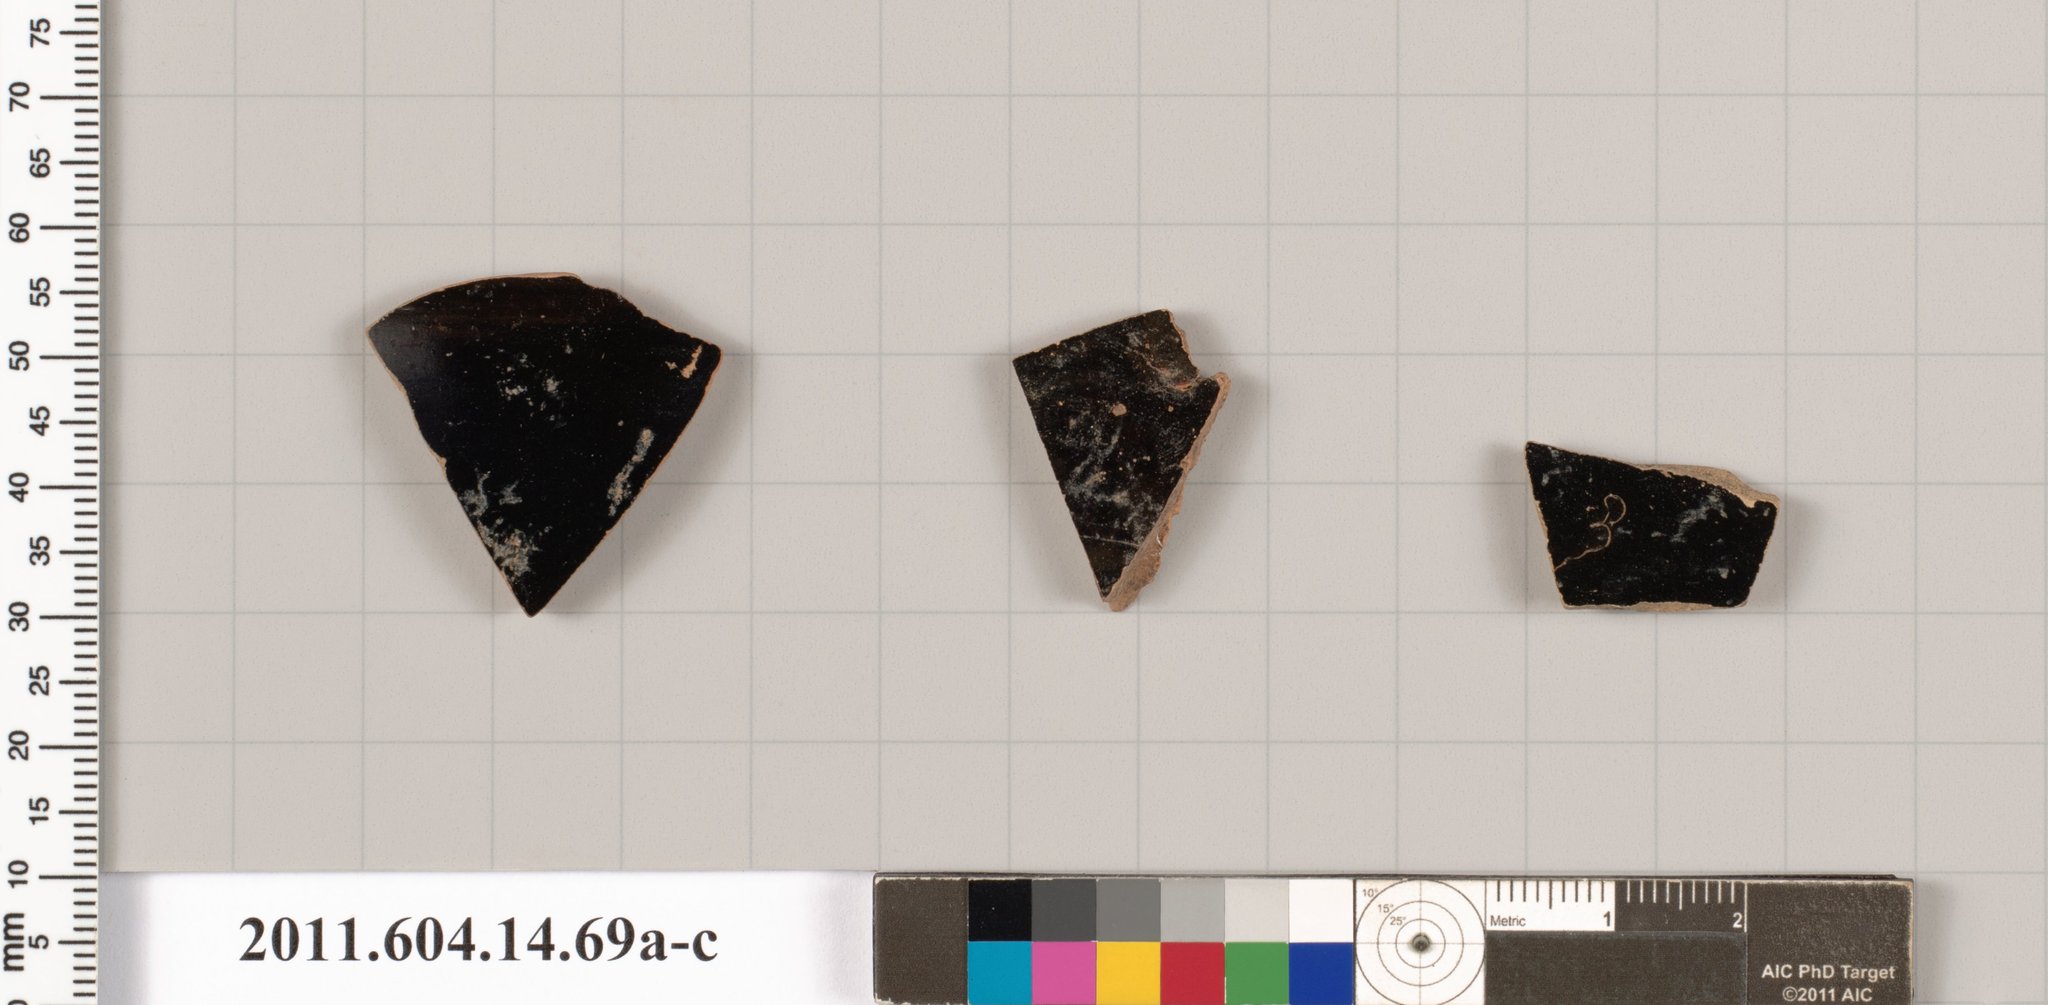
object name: kylix fragment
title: Terracotta fragments of kylikes (drinking cups)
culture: unknown fabric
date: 600-401 BCE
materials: terracotta